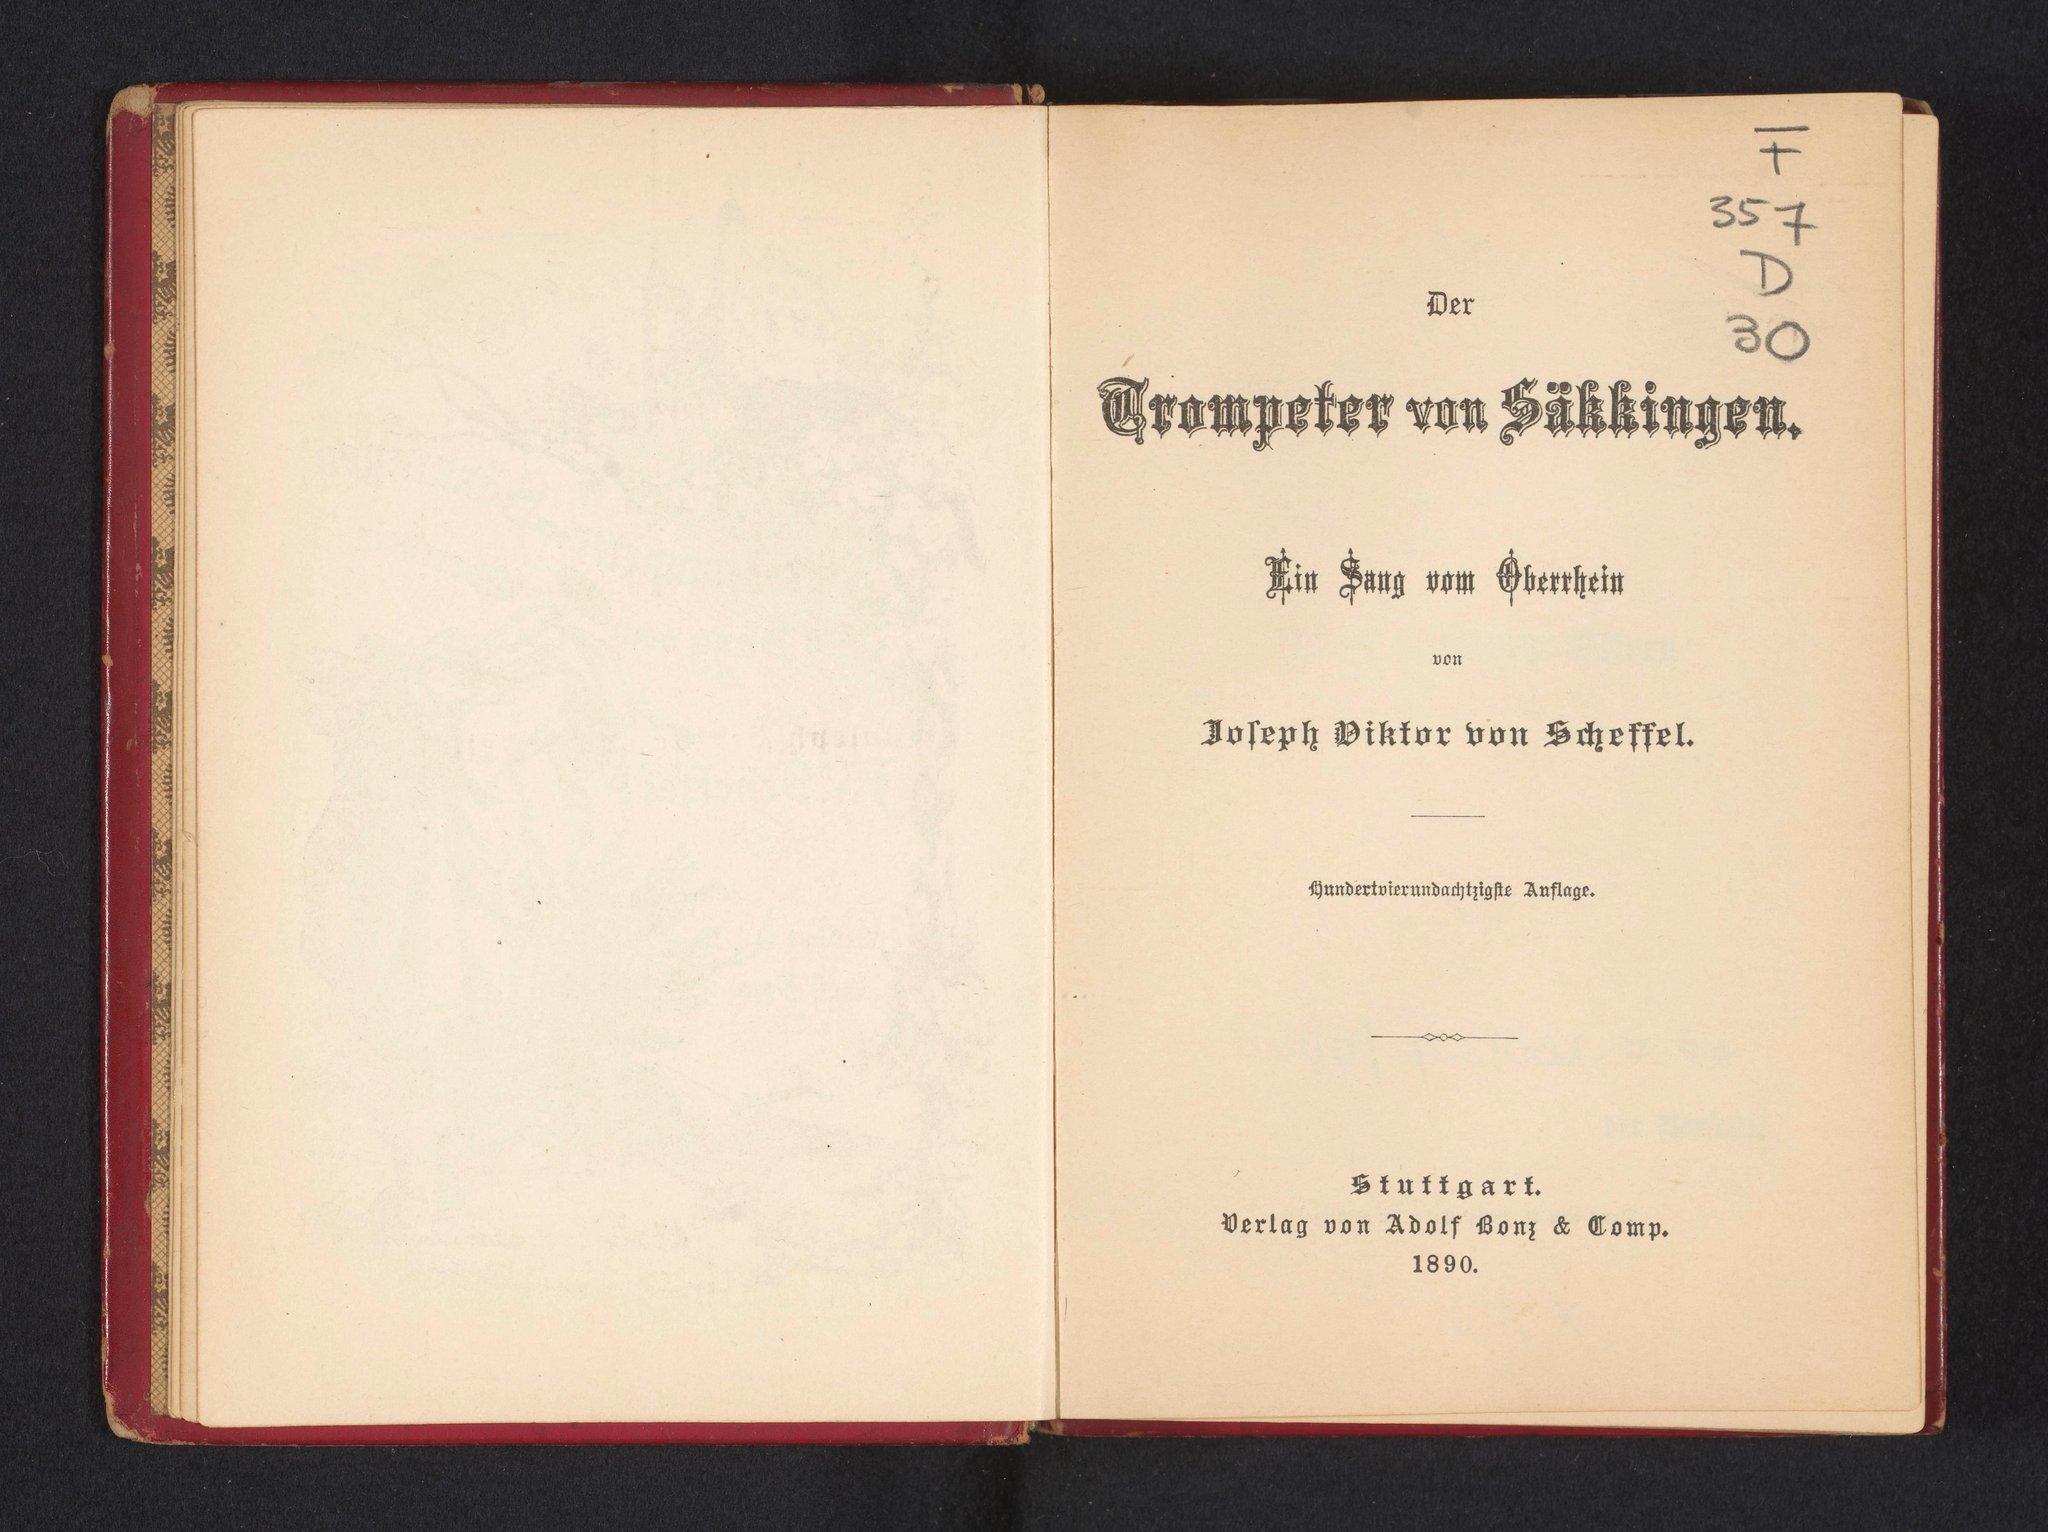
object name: book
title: Der Trompeter von Säkkingen : ein Sang vom Oberrhein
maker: joseph victor von scheffel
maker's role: dichter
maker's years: 1826-1886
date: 1890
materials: cardboard, leather, paper, photographic support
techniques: albumen print, decorated paper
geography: stuttgart